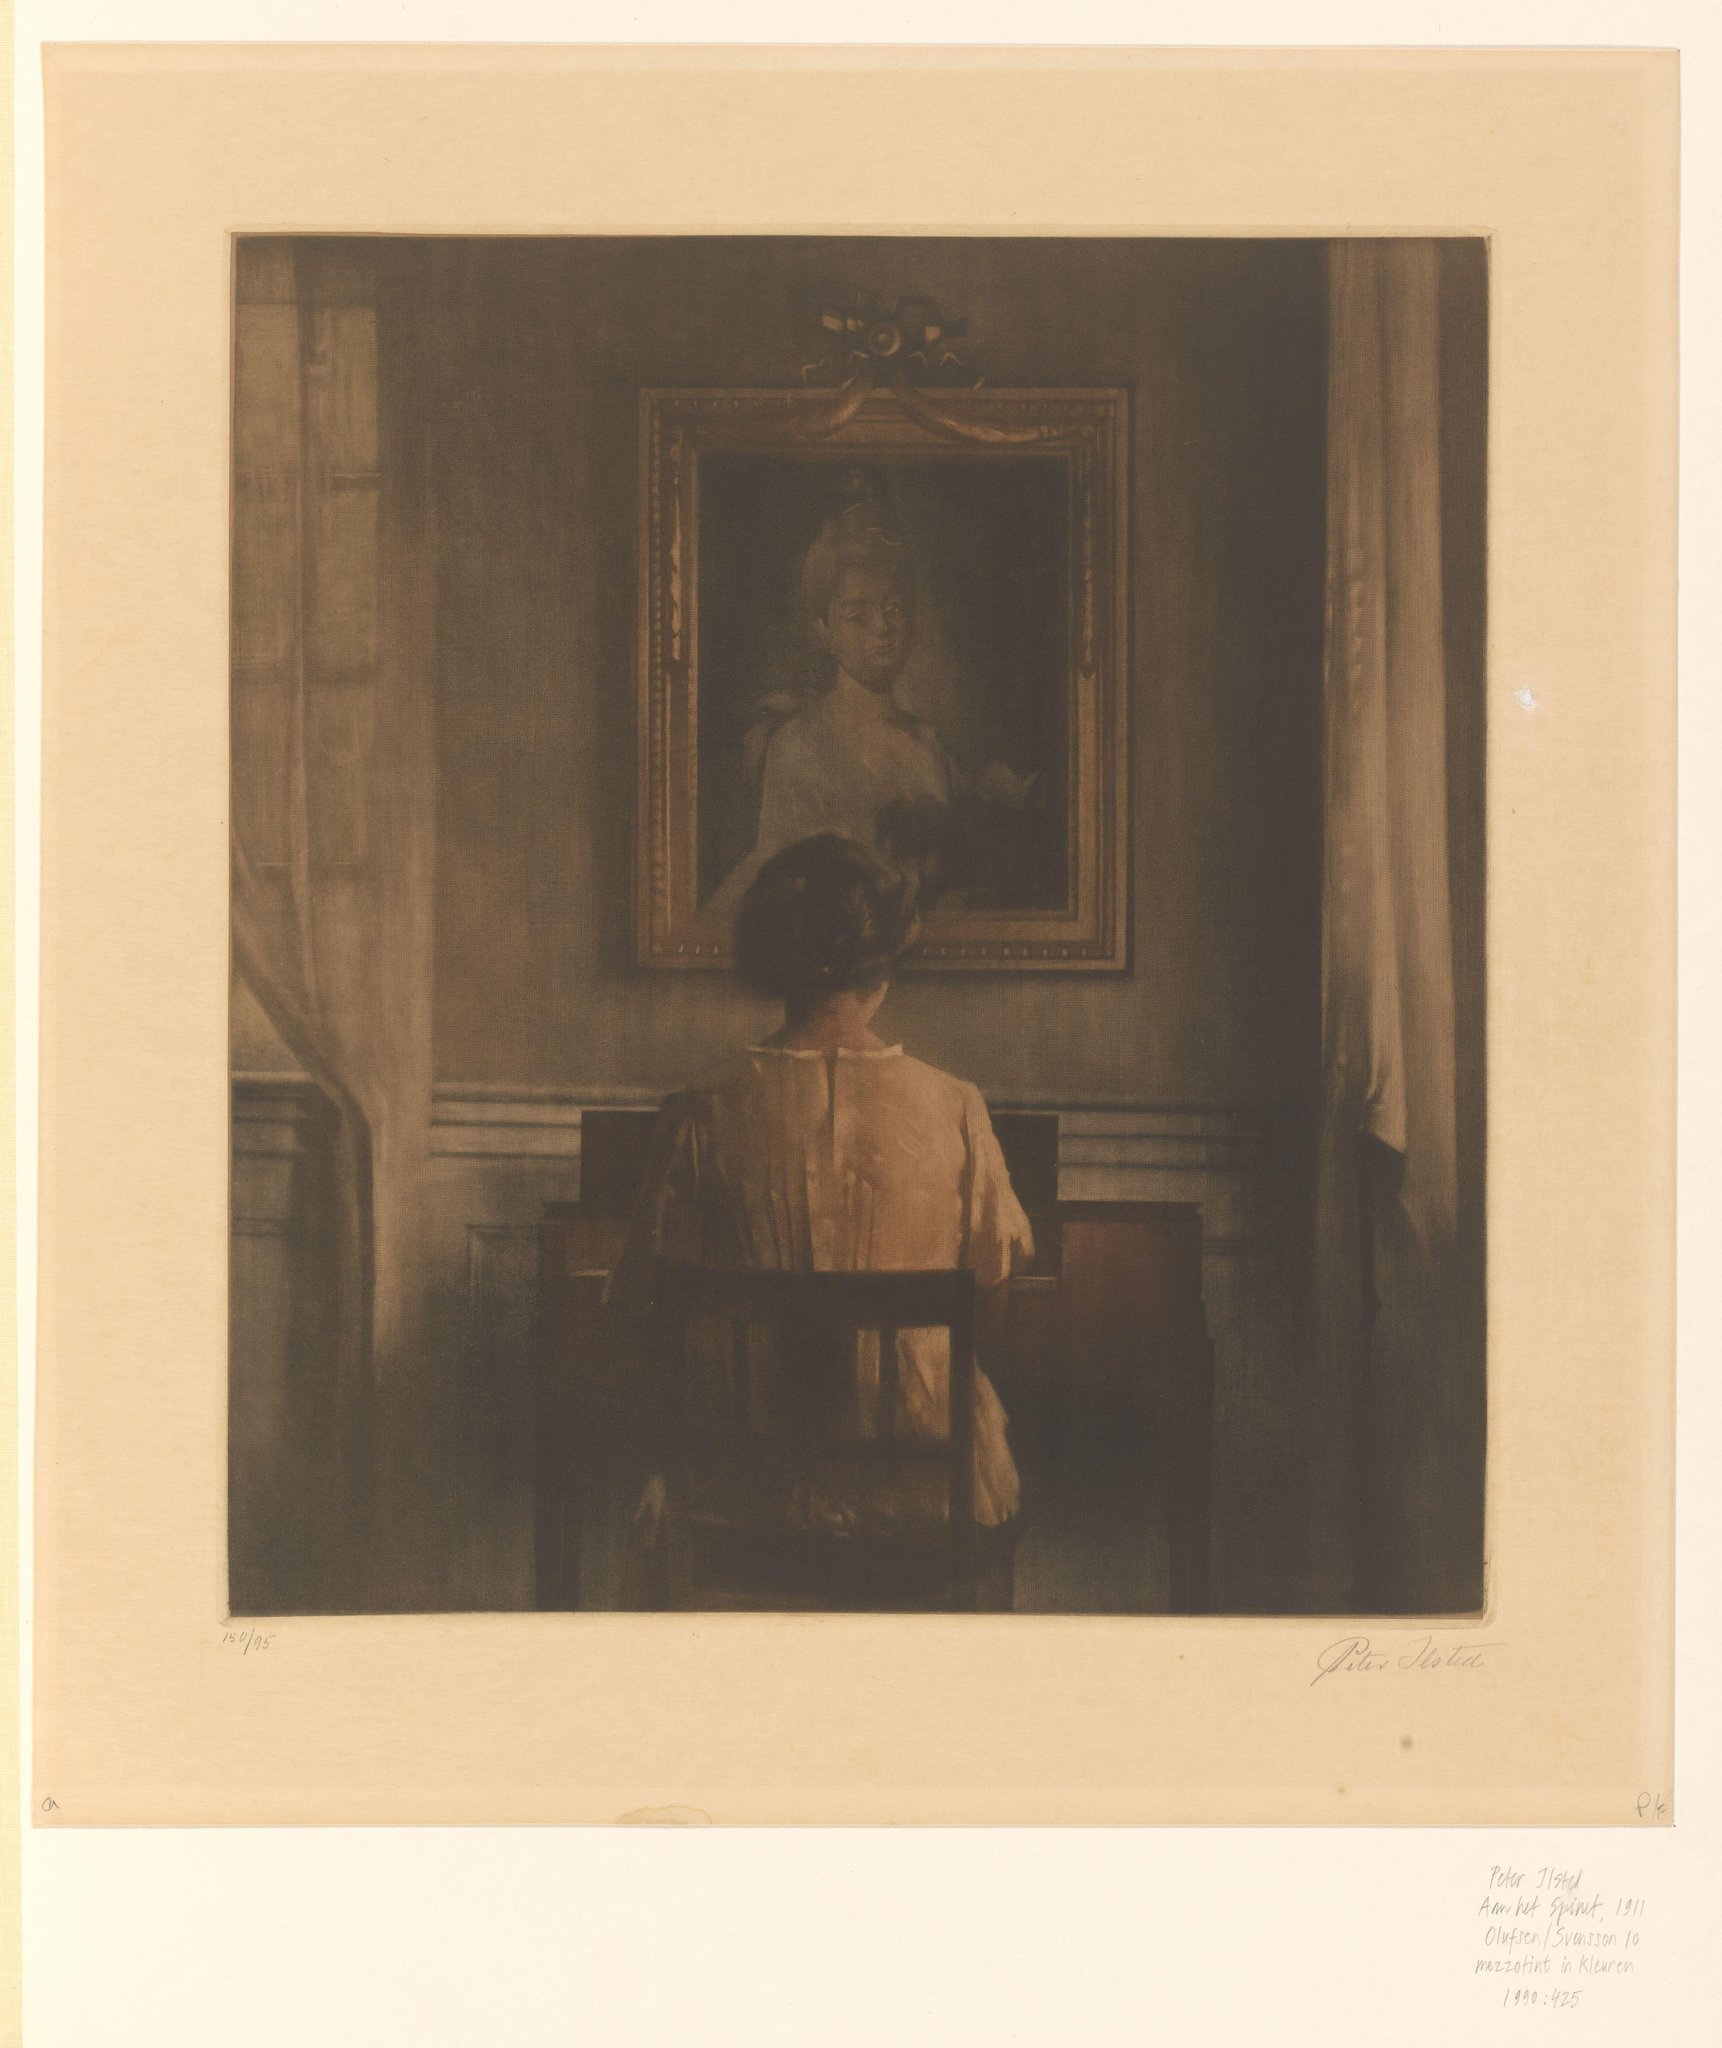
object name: print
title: Vrouw op de rug gezien, spelend op een spinet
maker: peter vilhelm ilsted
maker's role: print maker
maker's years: 1861-1933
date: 1911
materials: paper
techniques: color mezzotint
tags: adult woman, clavichord, harpsichord, picture, painting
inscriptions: collector's mark: Lugt 2228, collector's mark: Lugt 2760